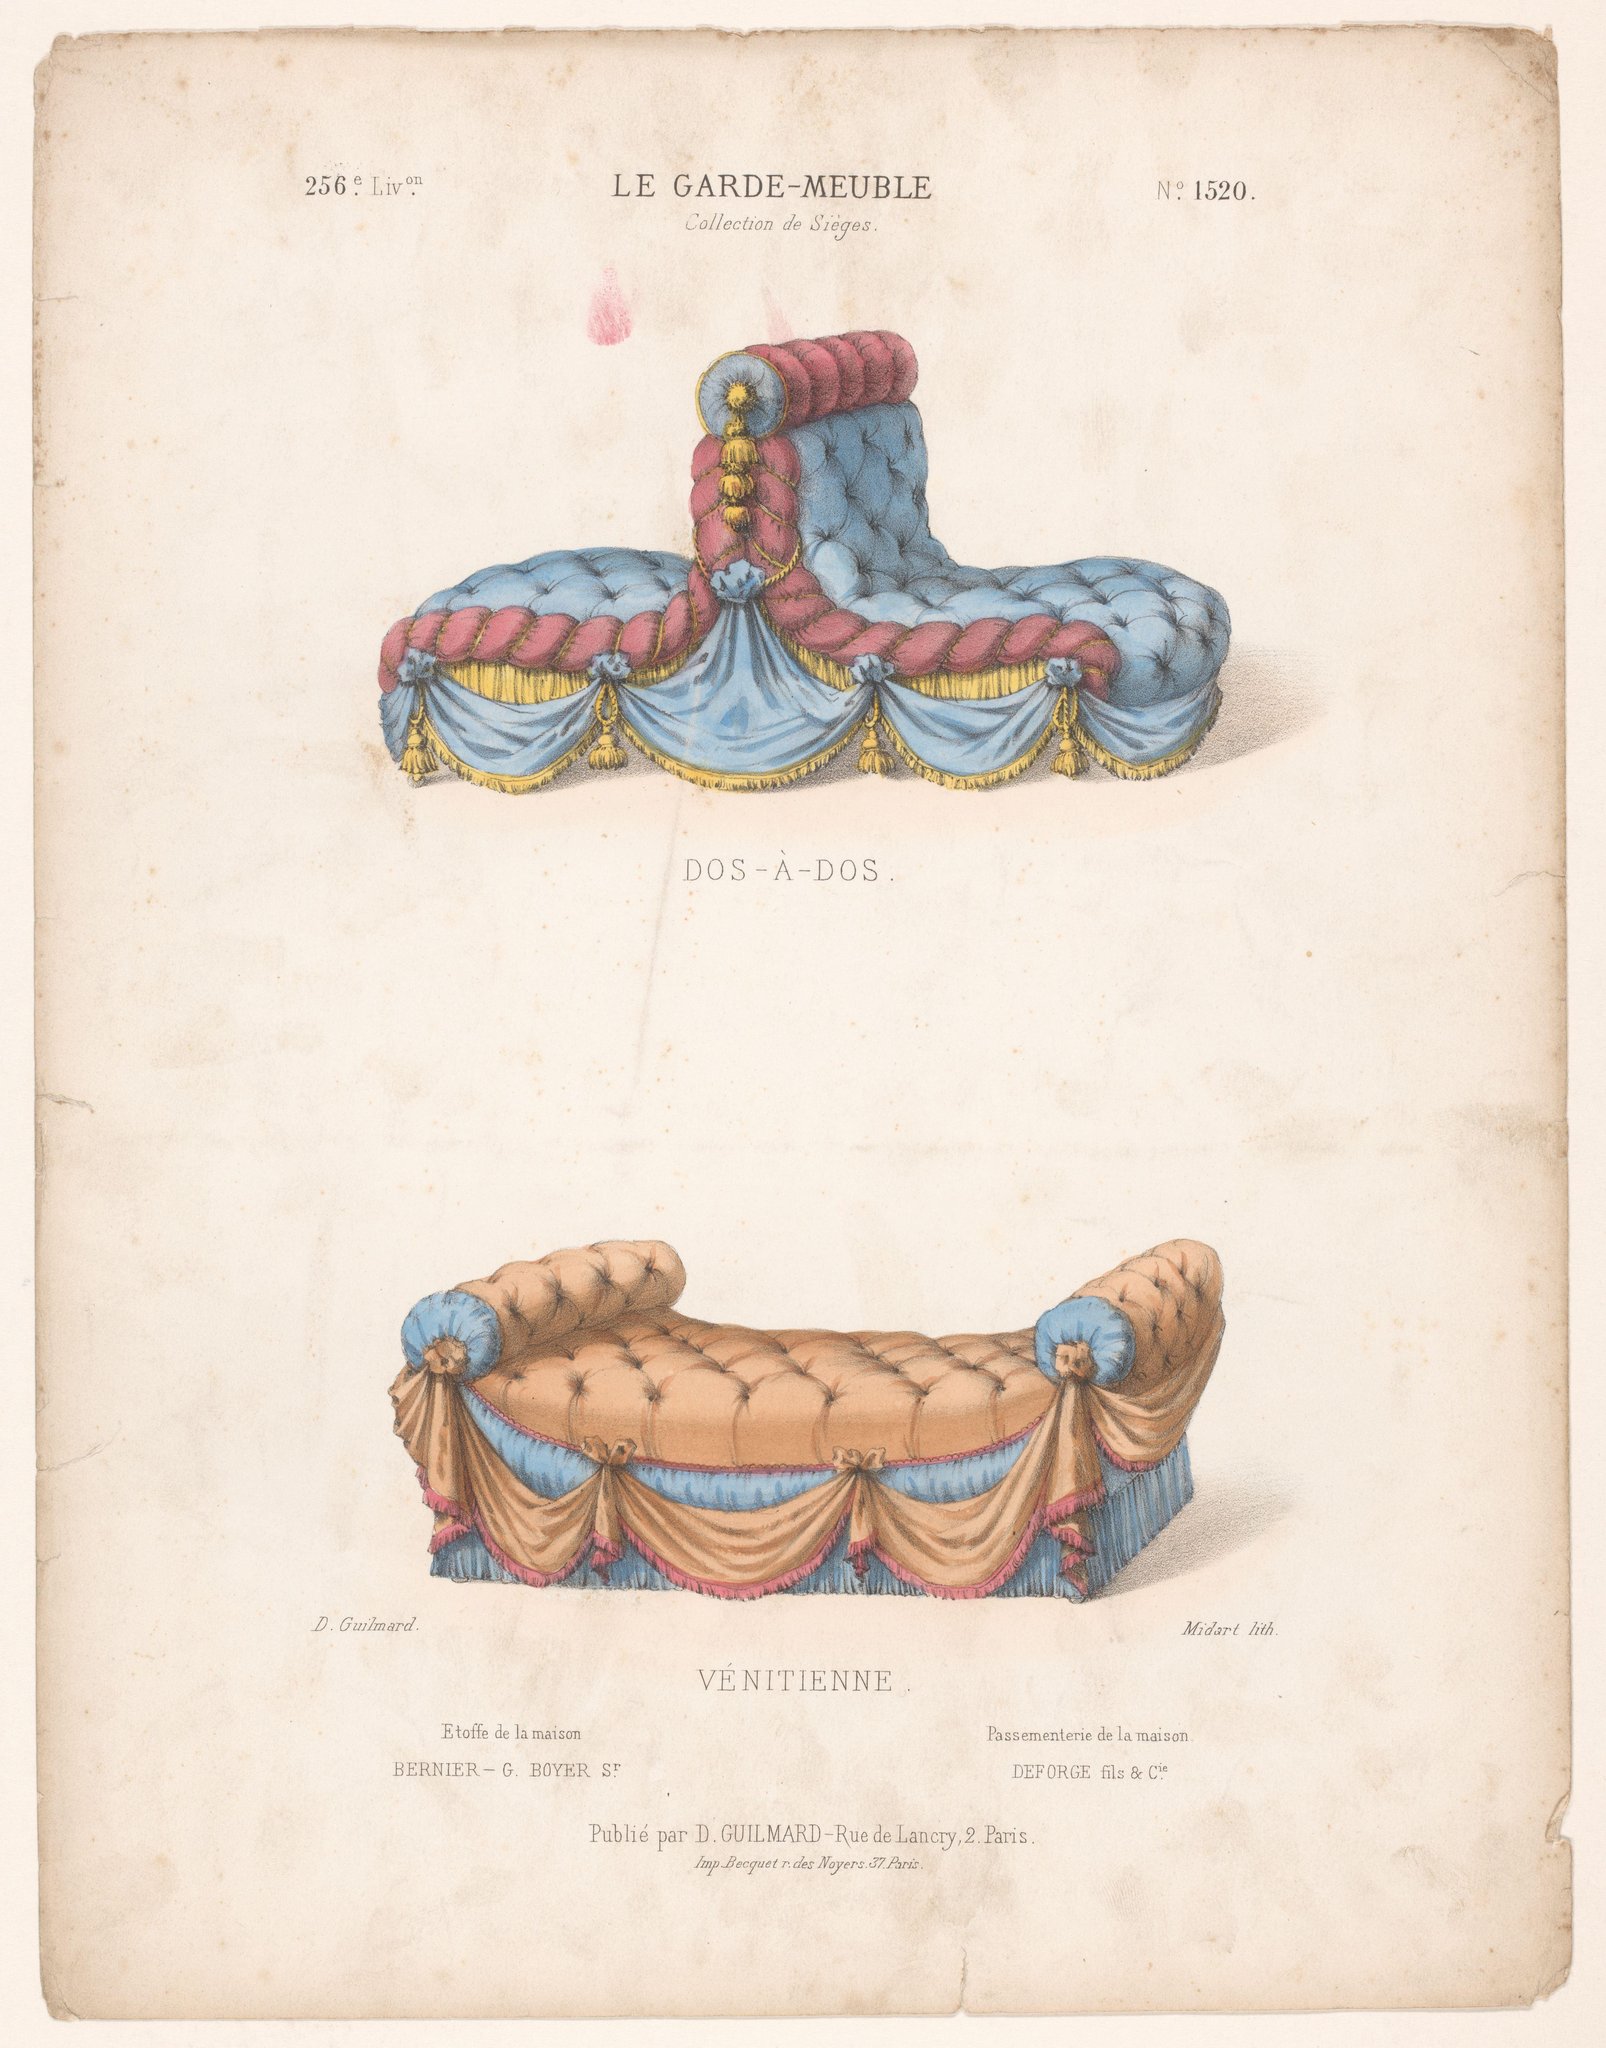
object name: print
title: Le garde-meuble / Collection de Sièges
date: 1839-1885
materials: paper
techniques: hand coloring, lithograph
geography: paris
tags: seating furniture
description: Ieder Livraison in de serie Le Garde-Meuble bevat negen platen: drie 'sièges' (zitmeubels), drie 'meubles' (diverse meubels zoals tafels en kasten) en drie 'tentures' (gordijnen en draperieën).